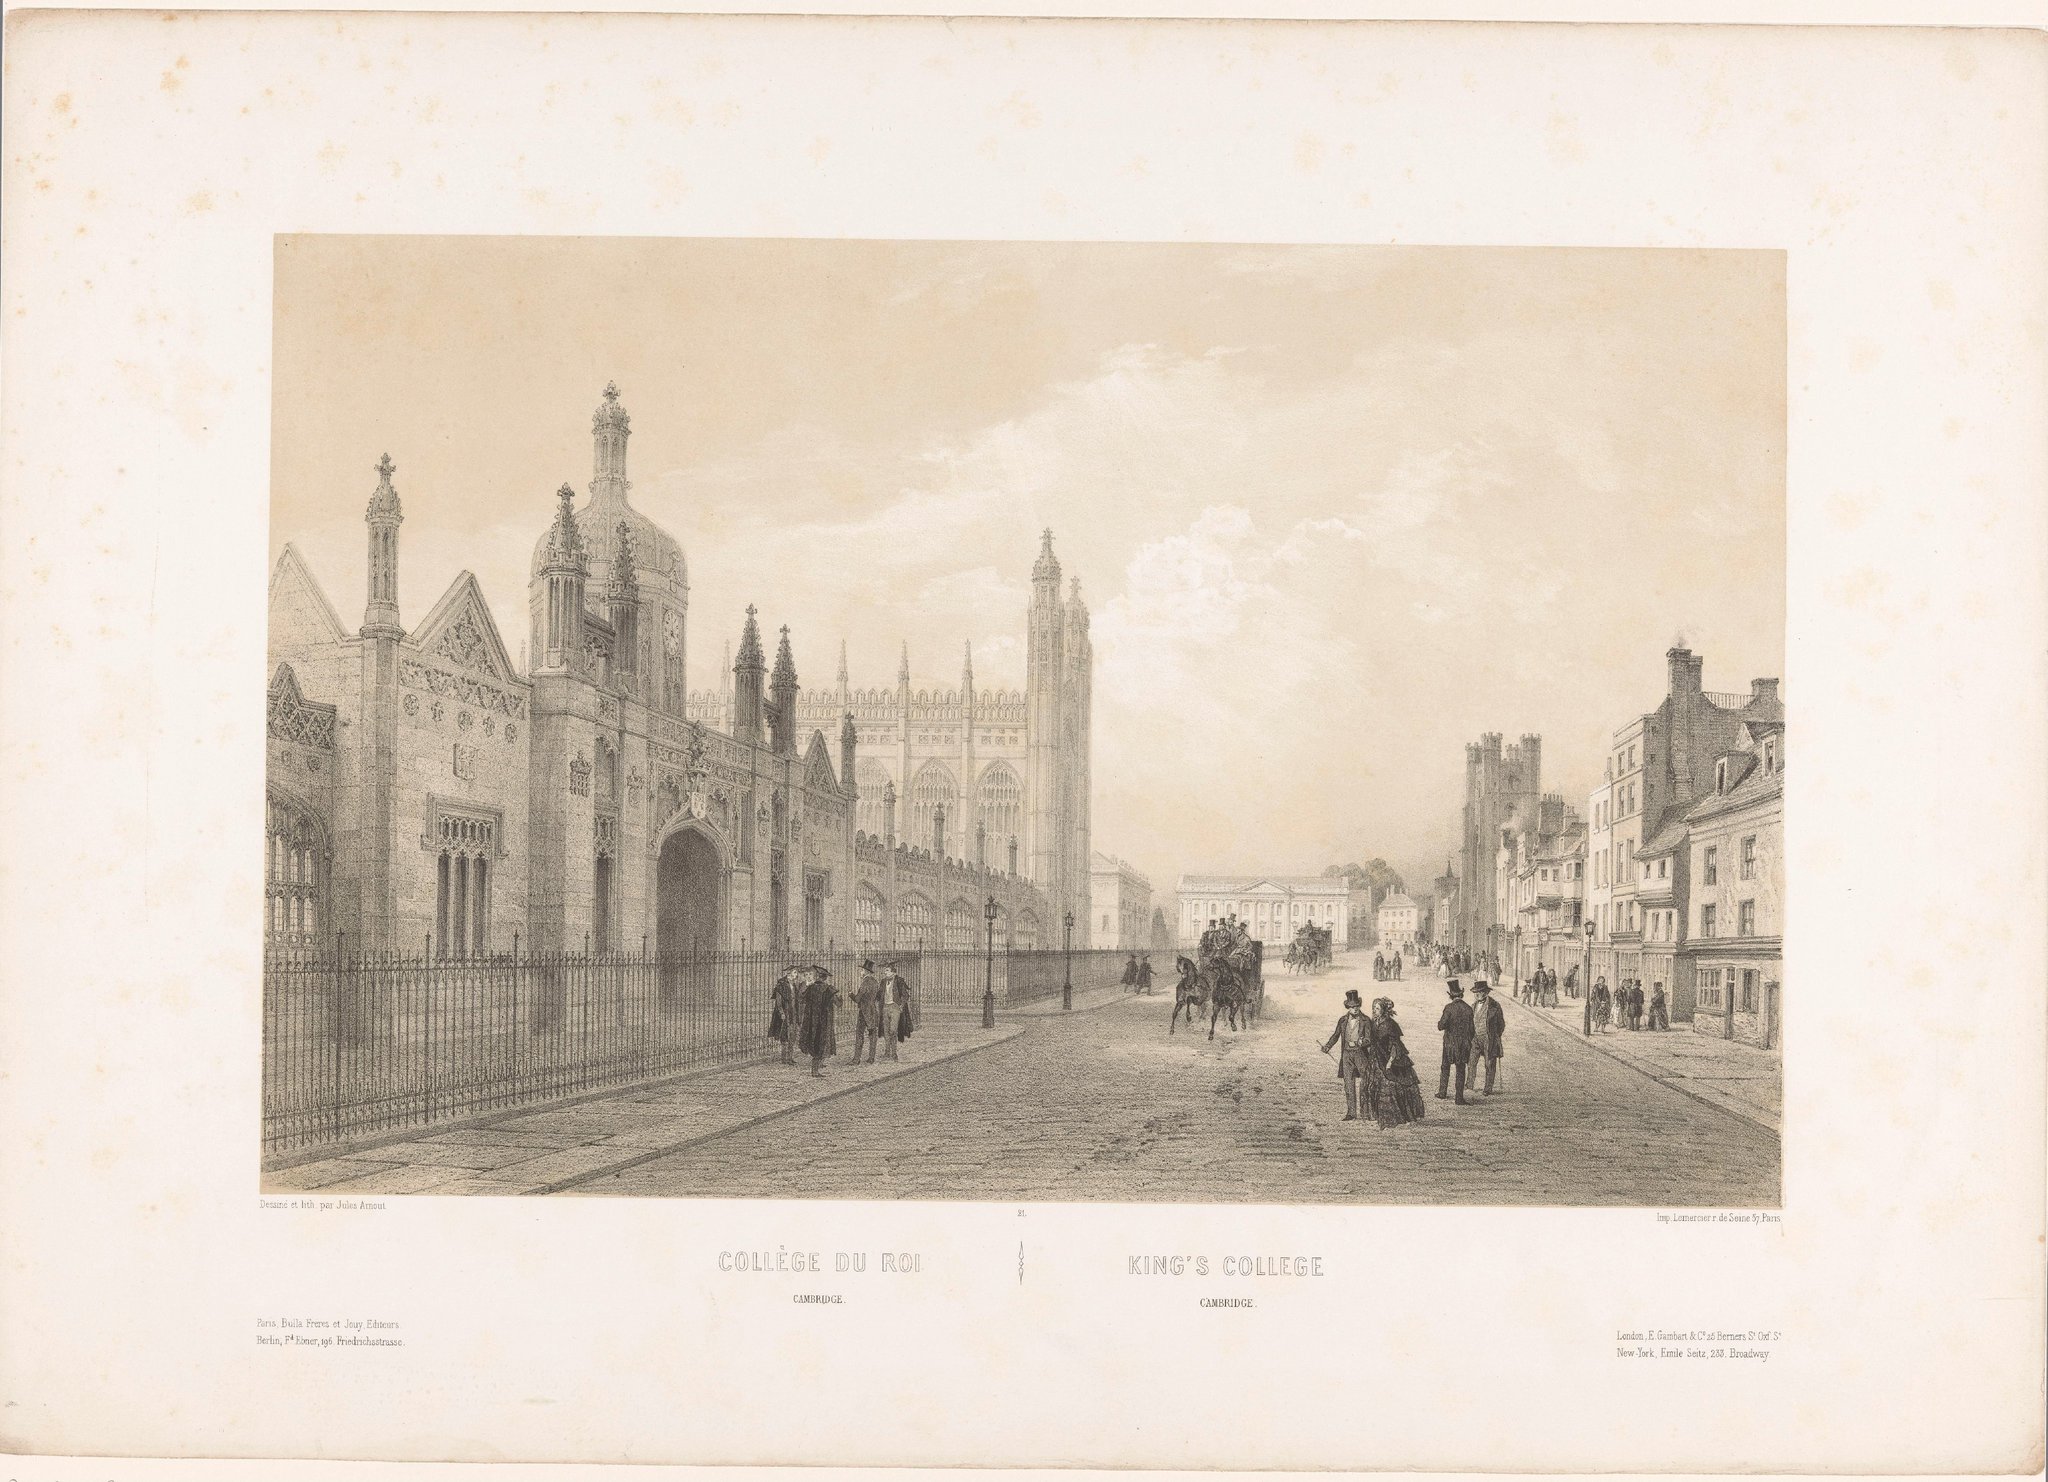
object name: print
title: England, Ireland & Scotland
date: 1855-1856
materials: paper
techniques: tone lithography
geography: paris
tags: university building, college, avenue, boulevard, promenade, esplanade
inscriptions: collector's mark: Lugt 2228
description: De serie werd aanvankelijk uitgegeven door Sinnett (Londen) en Ducollet (Parijs) in 1847. In 1855-1856 verscheen een heruitgave en vervolg van de serie bij Gambart (Londen) en Bulla (Parijs).